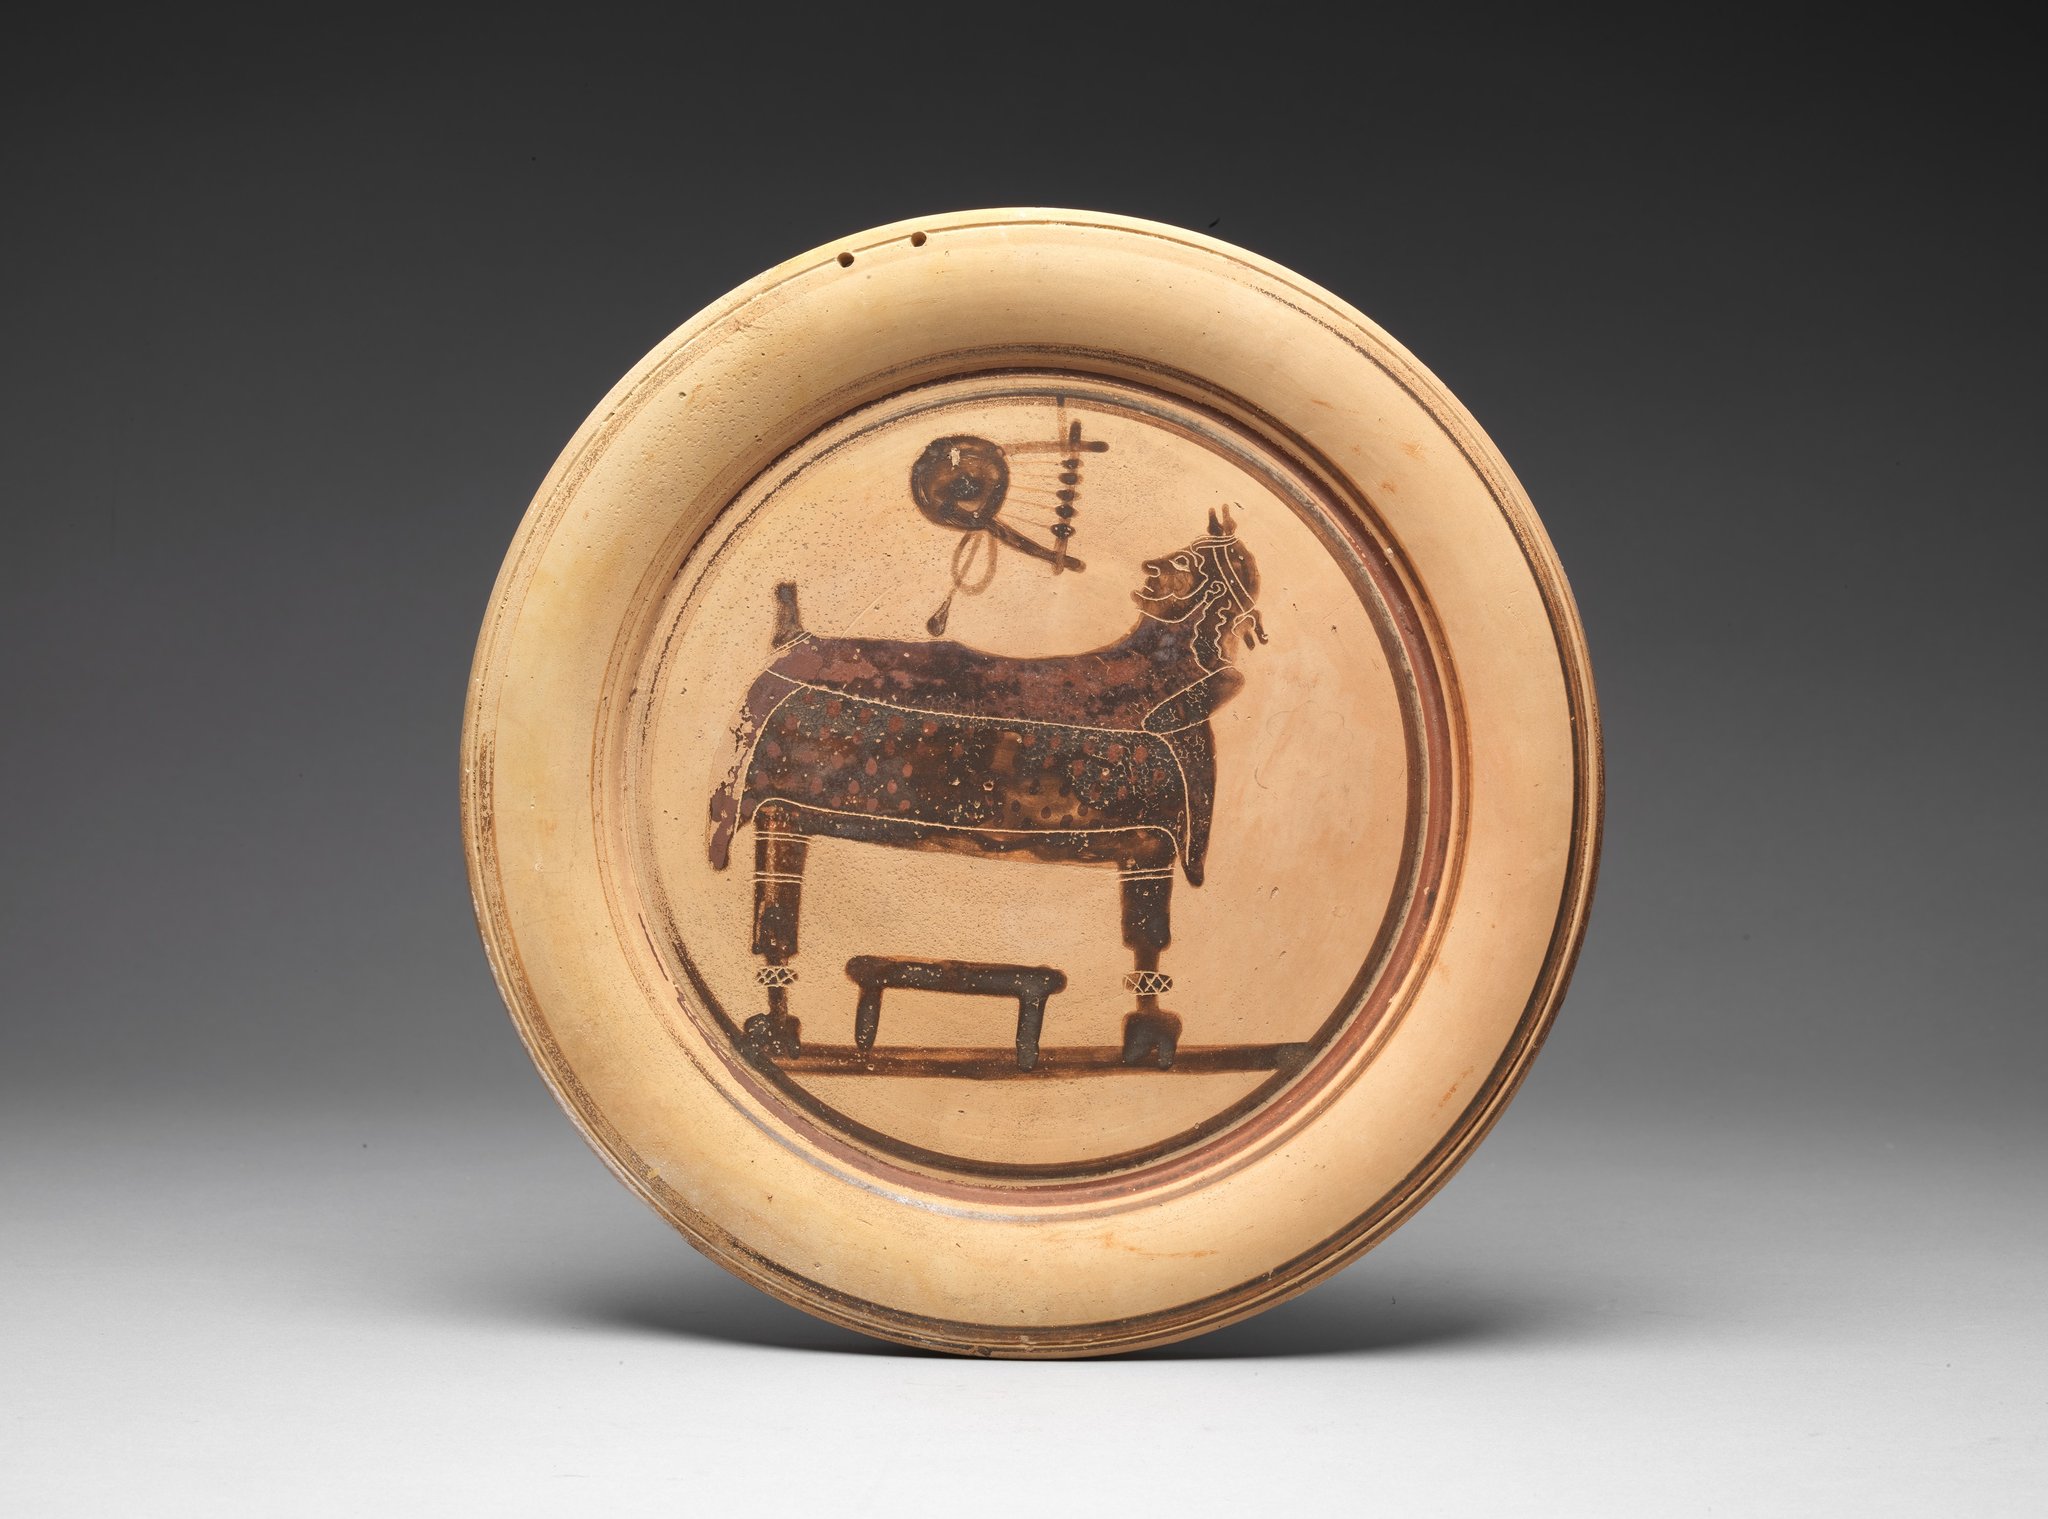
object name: plate with poet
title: Terracotta plate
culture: greek, corinthian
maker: chimaera painter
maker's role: artist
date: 595-570 BCE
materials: terracotta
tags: men,beds,lyres